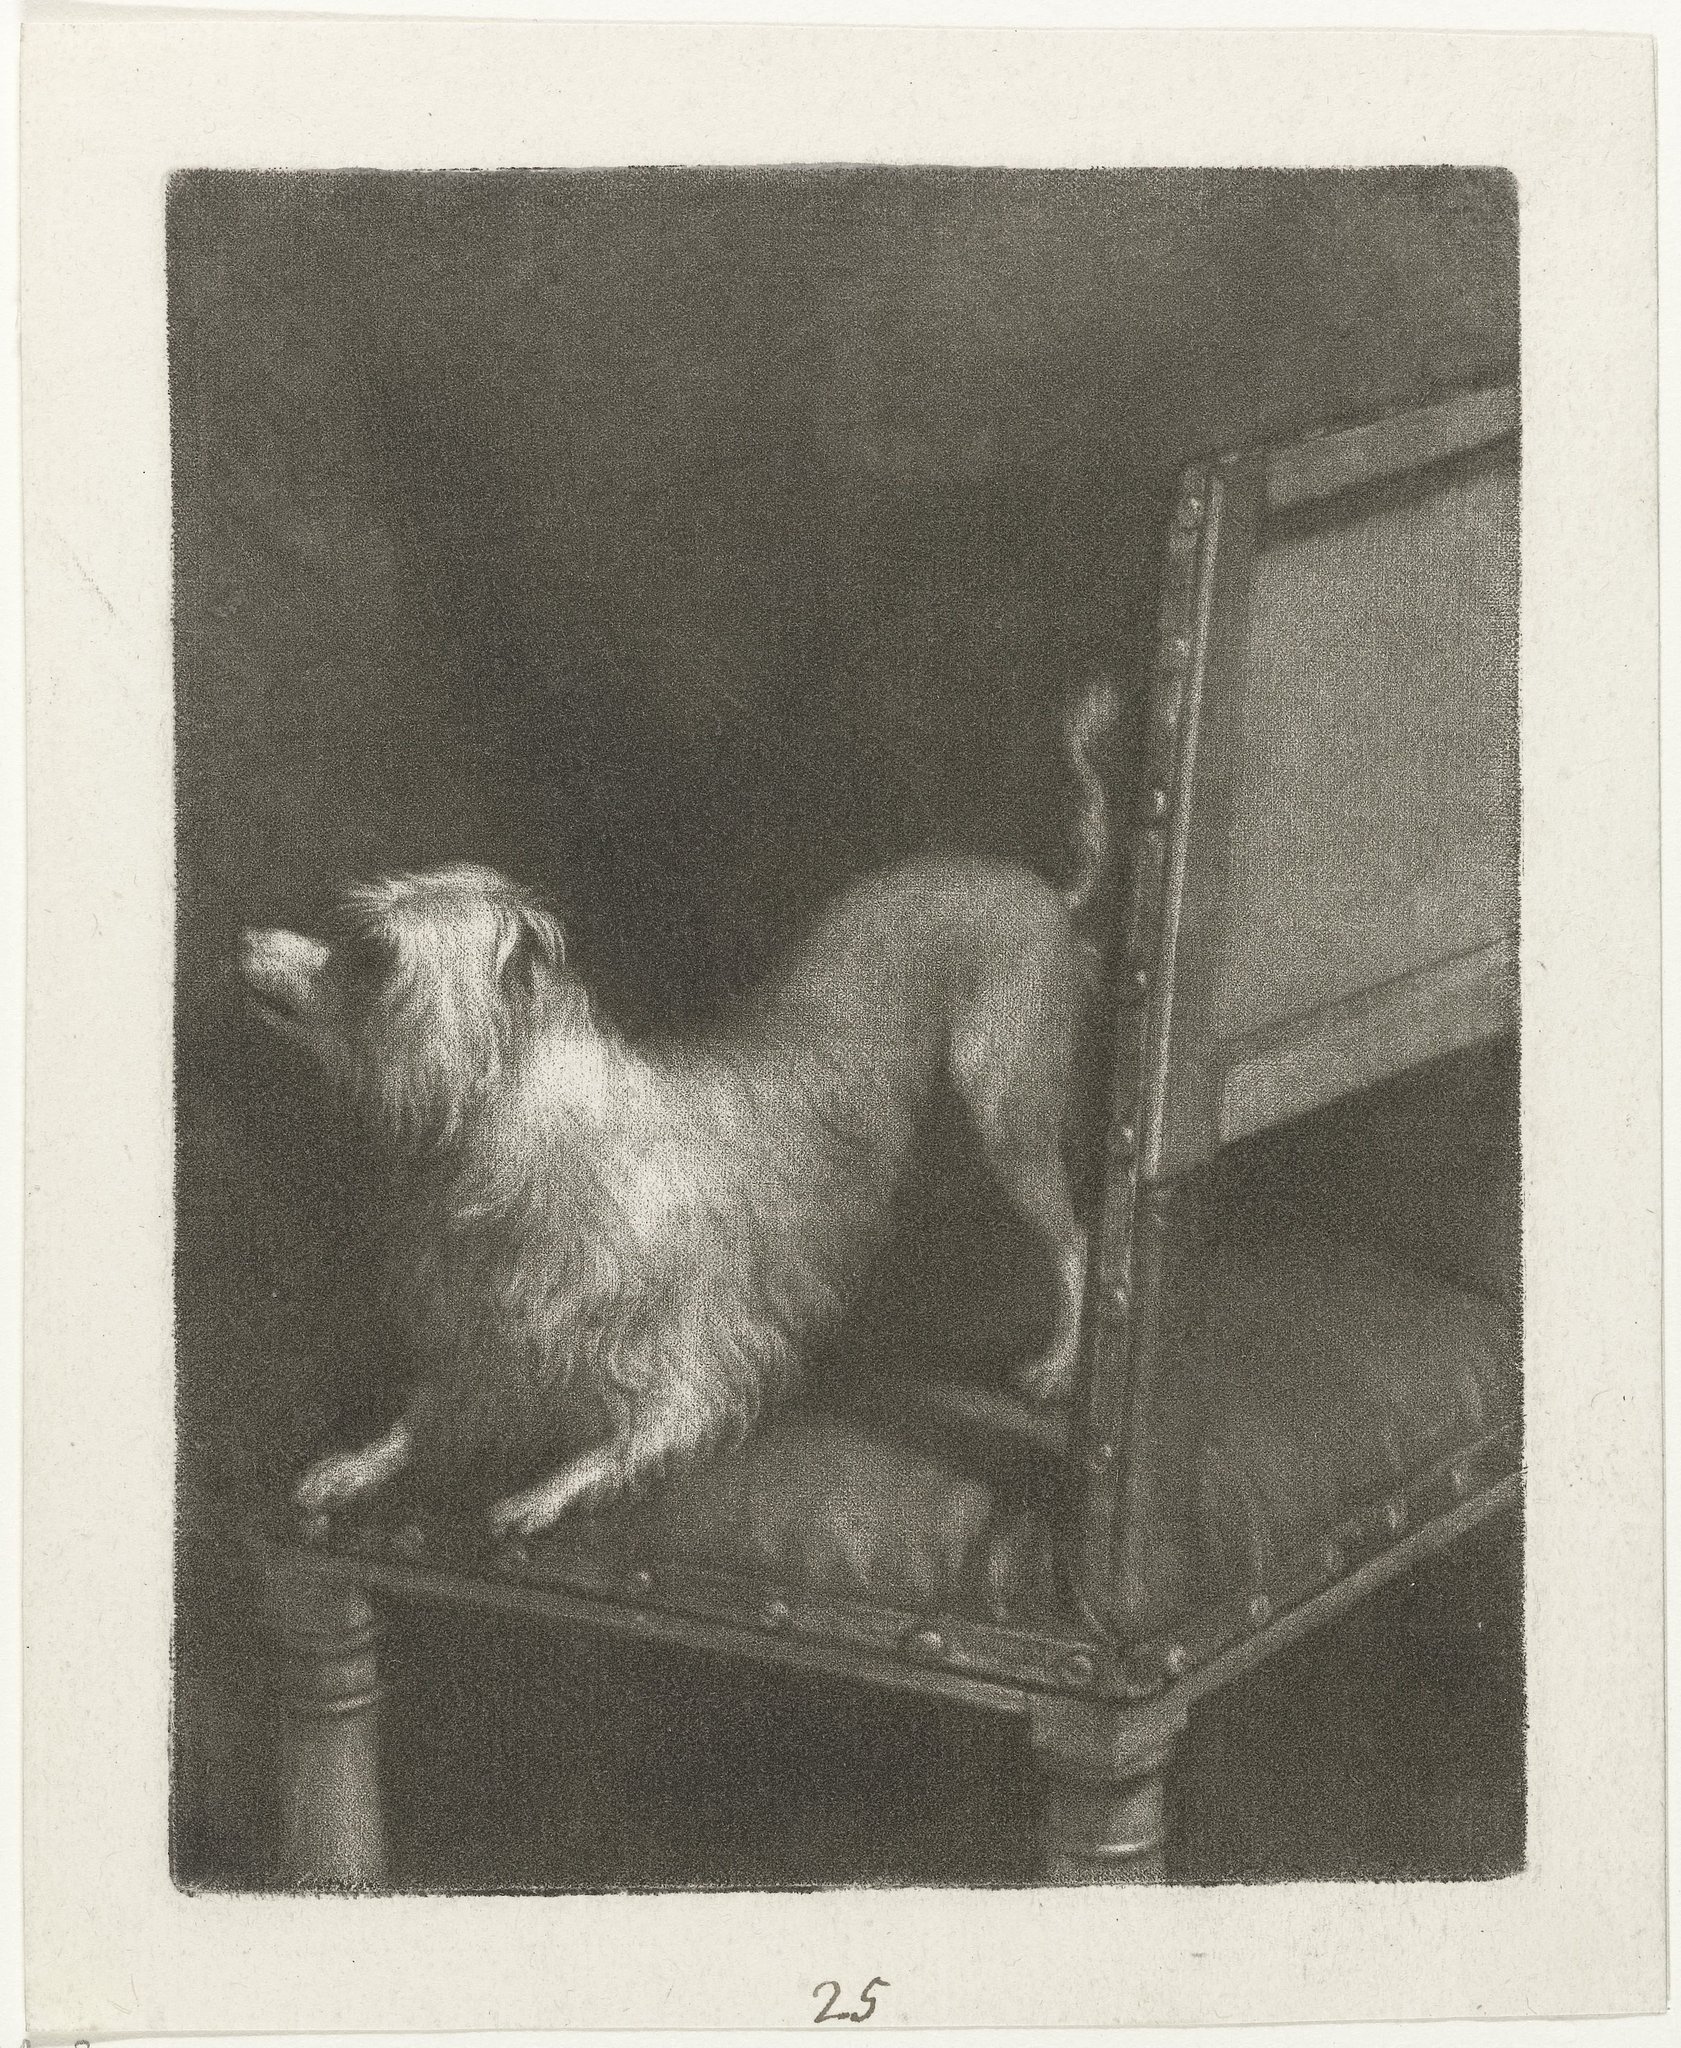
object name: print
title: Hondje op een stoel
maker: nicolaas verkolje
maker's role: draughtsman, painter, print maker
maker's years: 1673-1746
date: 1683-1746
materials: paper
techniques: mezzotint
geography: amsterdam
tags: dog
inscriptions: collector's mark: Lugt 240